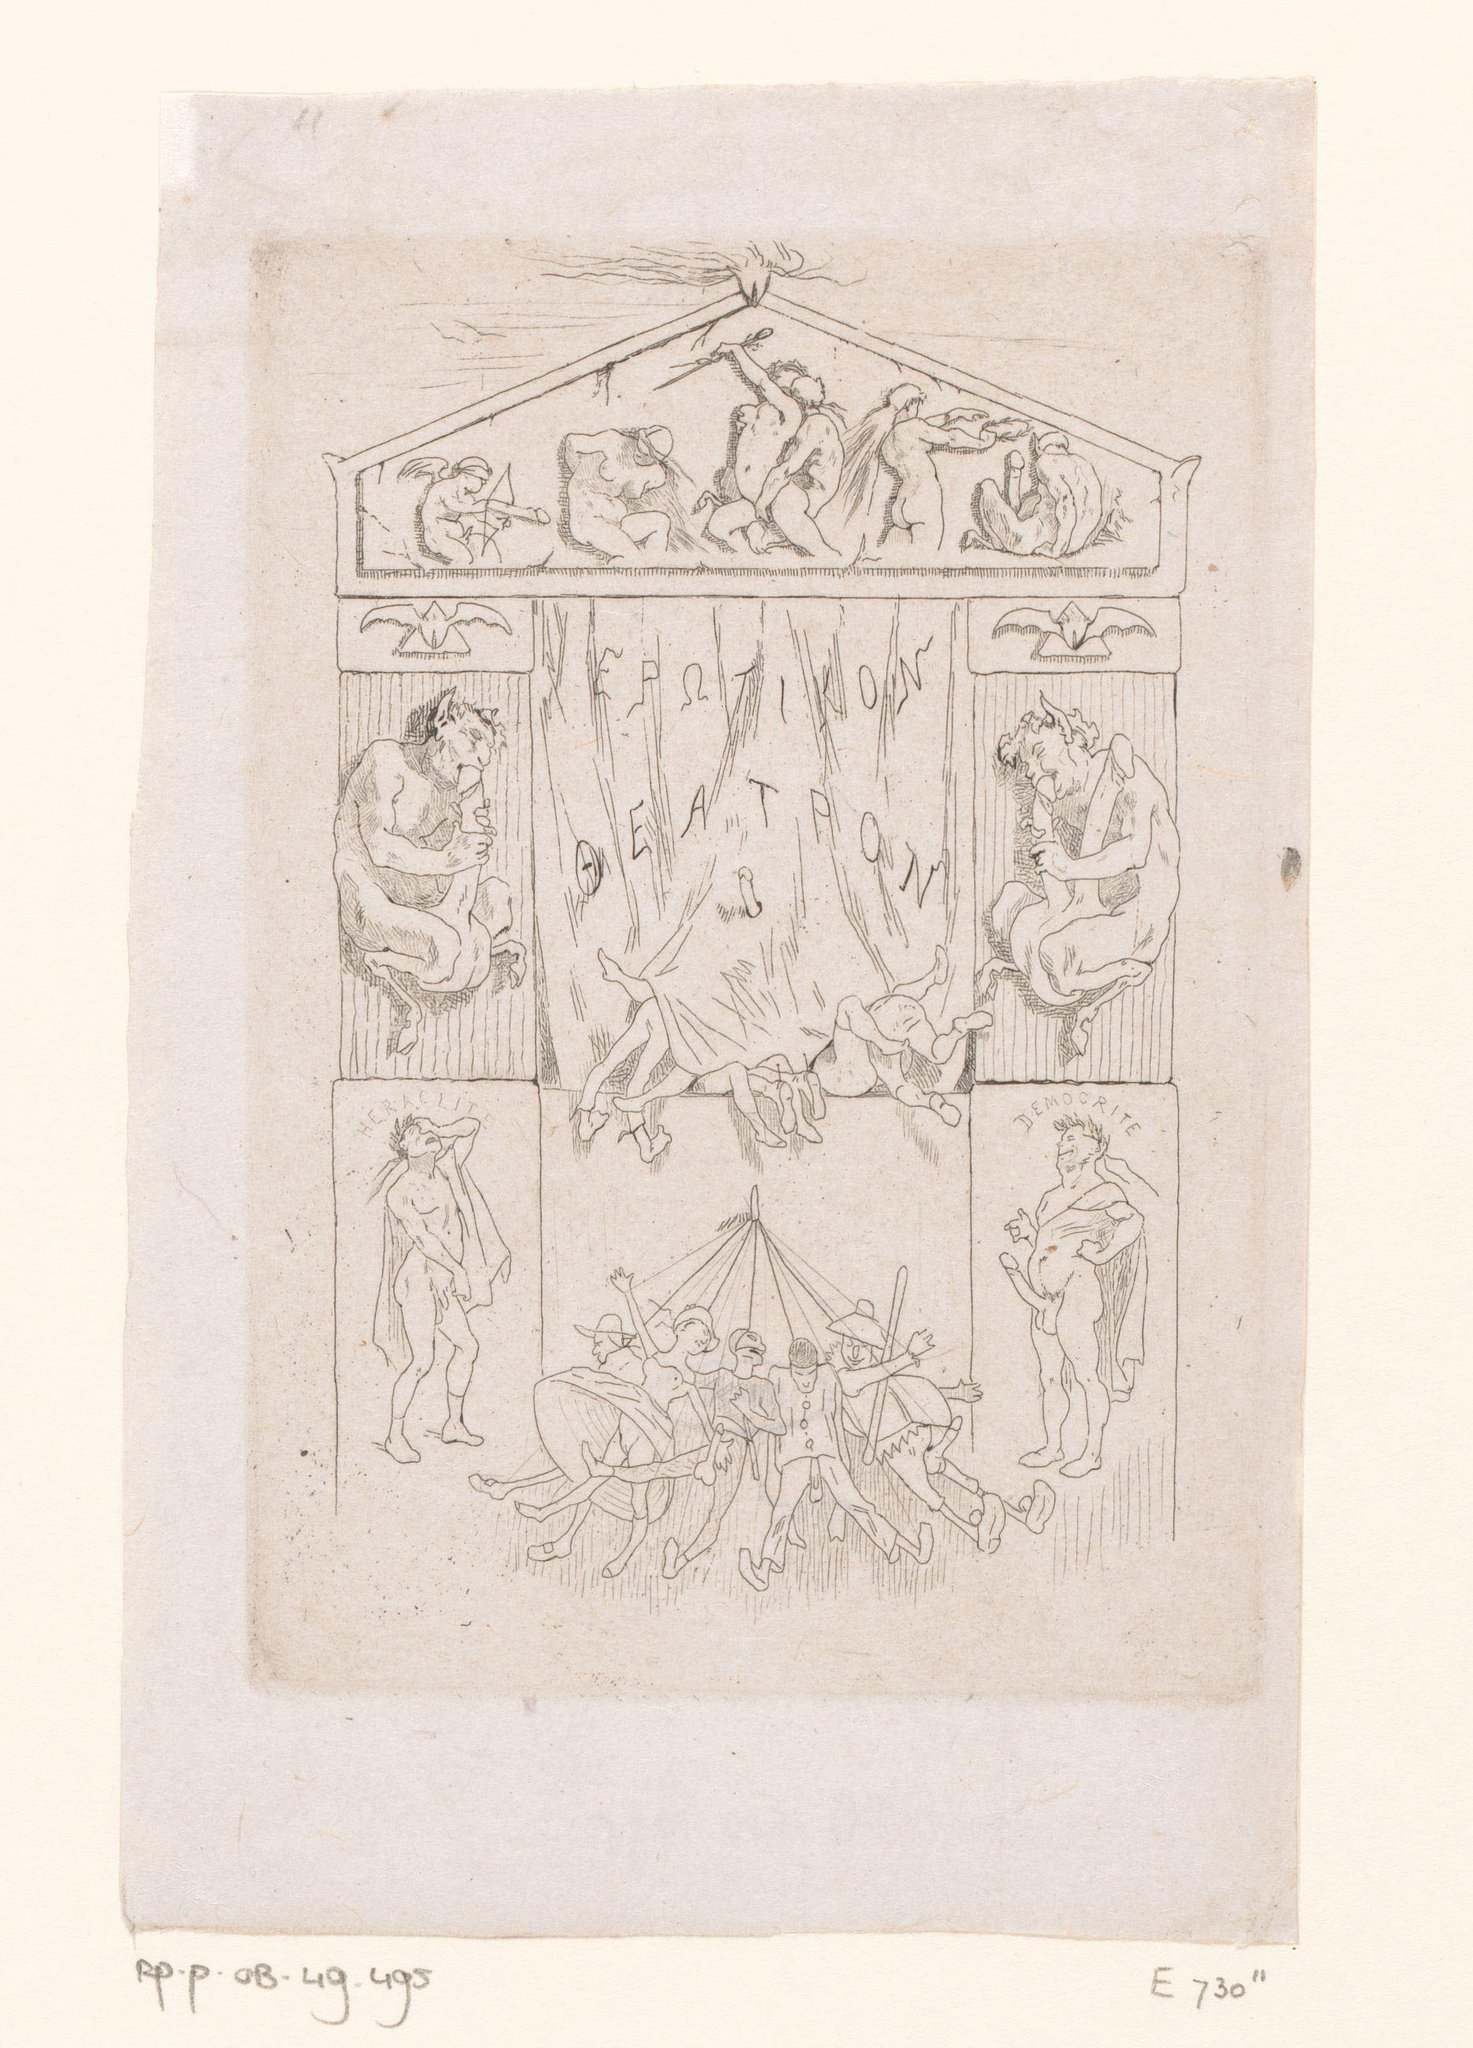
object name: print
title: Poppenkast gedecoreerd met erotisch mythologische scènes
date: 1864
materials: paper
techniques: etching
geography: paris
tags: puppet, satyrs, fauns, sileni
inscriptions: collector's mark: Lugt 2228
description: Pren uit: La théâtre érotique de la rue de la Santé. 2 dln. Brussel: s.n., 1864.